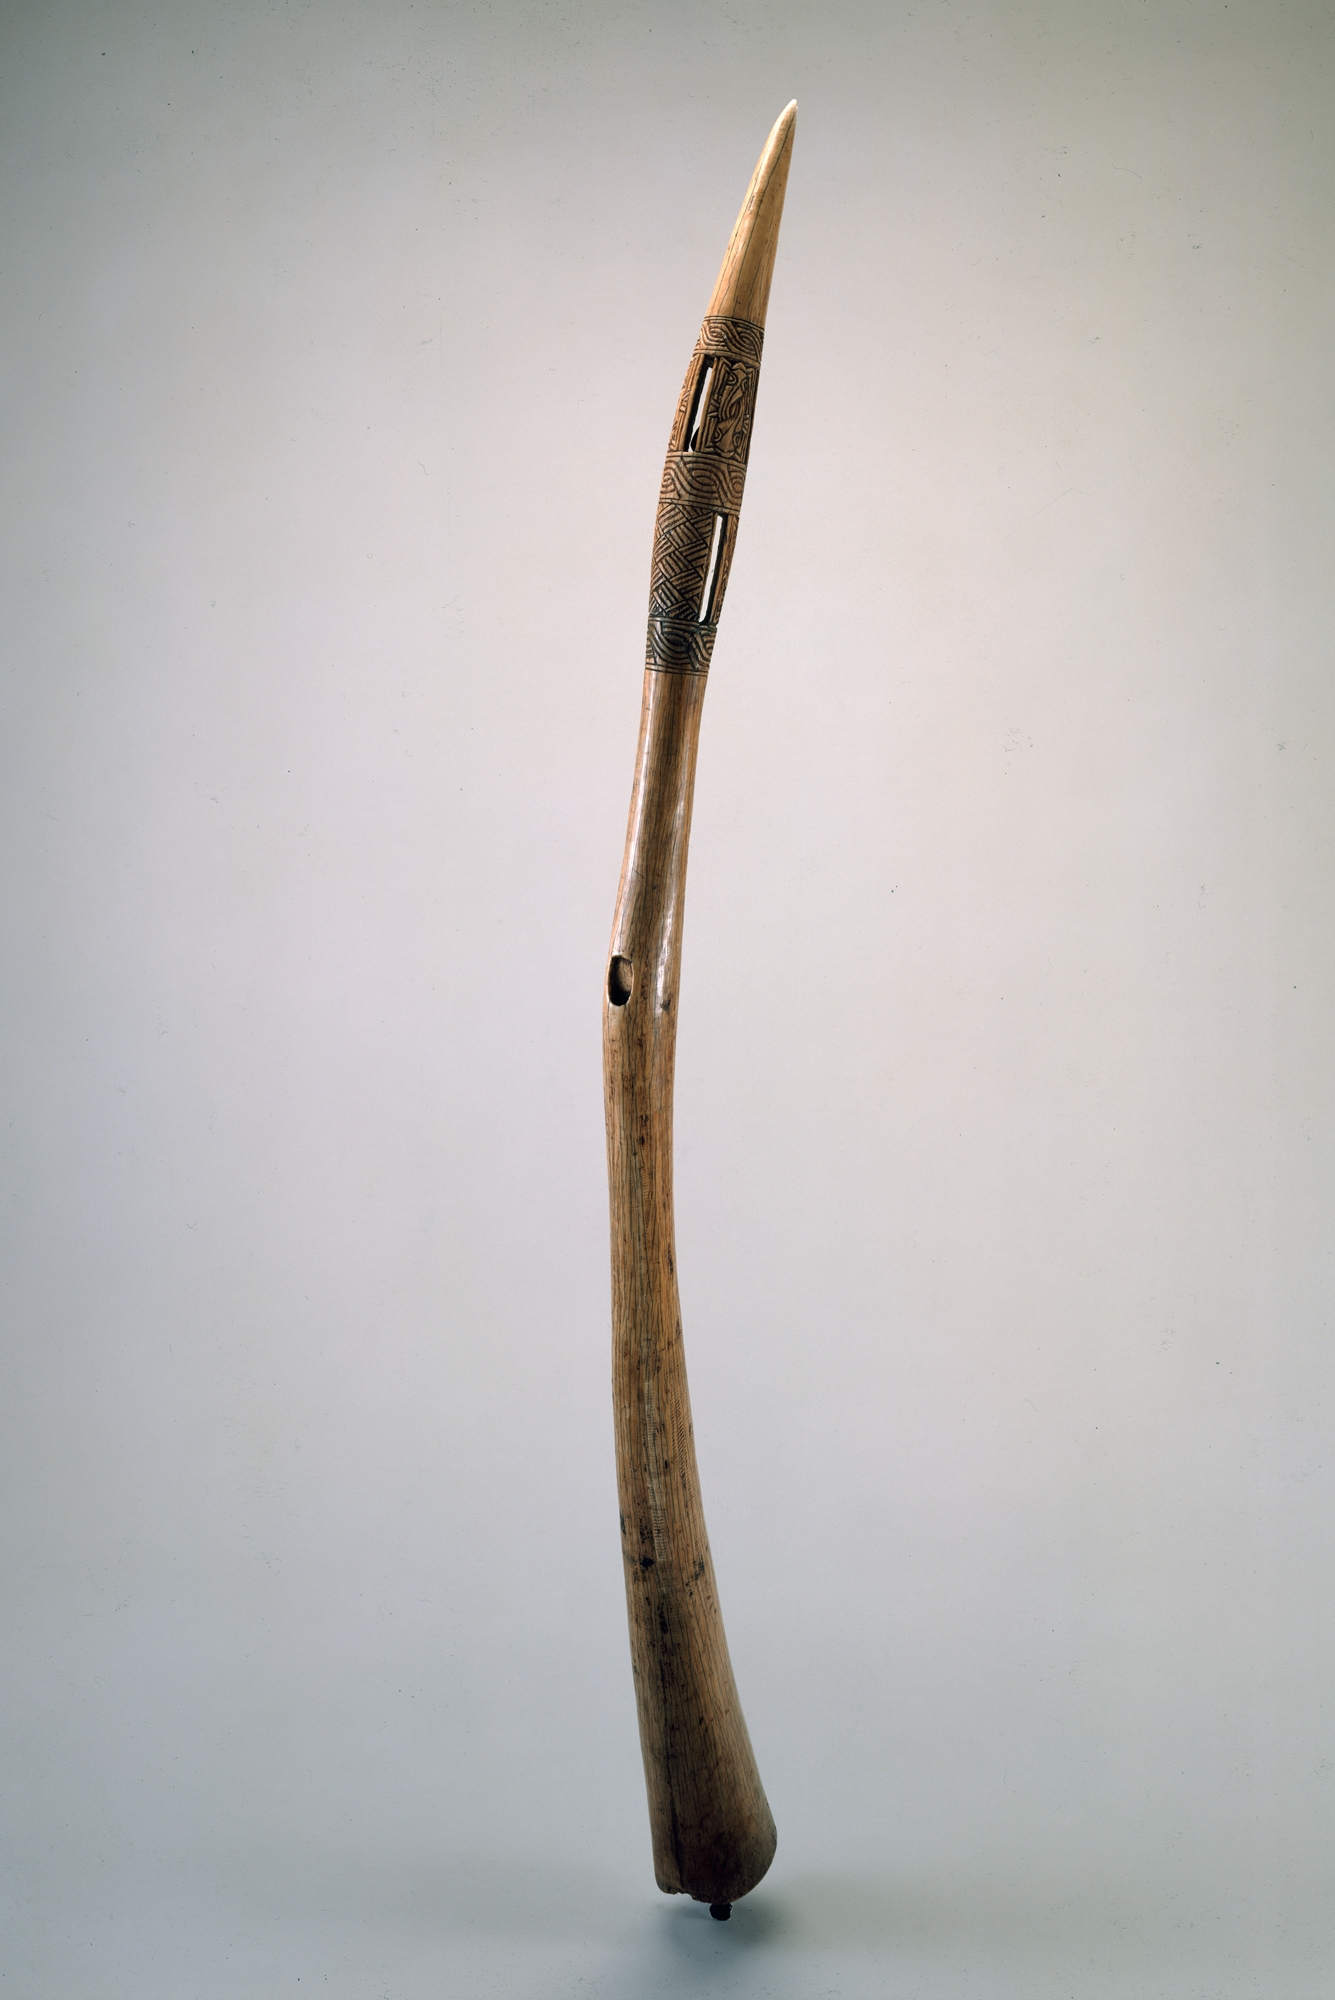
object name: trumpet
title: Side-blown Trumpet (Akohen)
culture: edo period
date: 1701-1900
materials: ivory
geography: nigeria